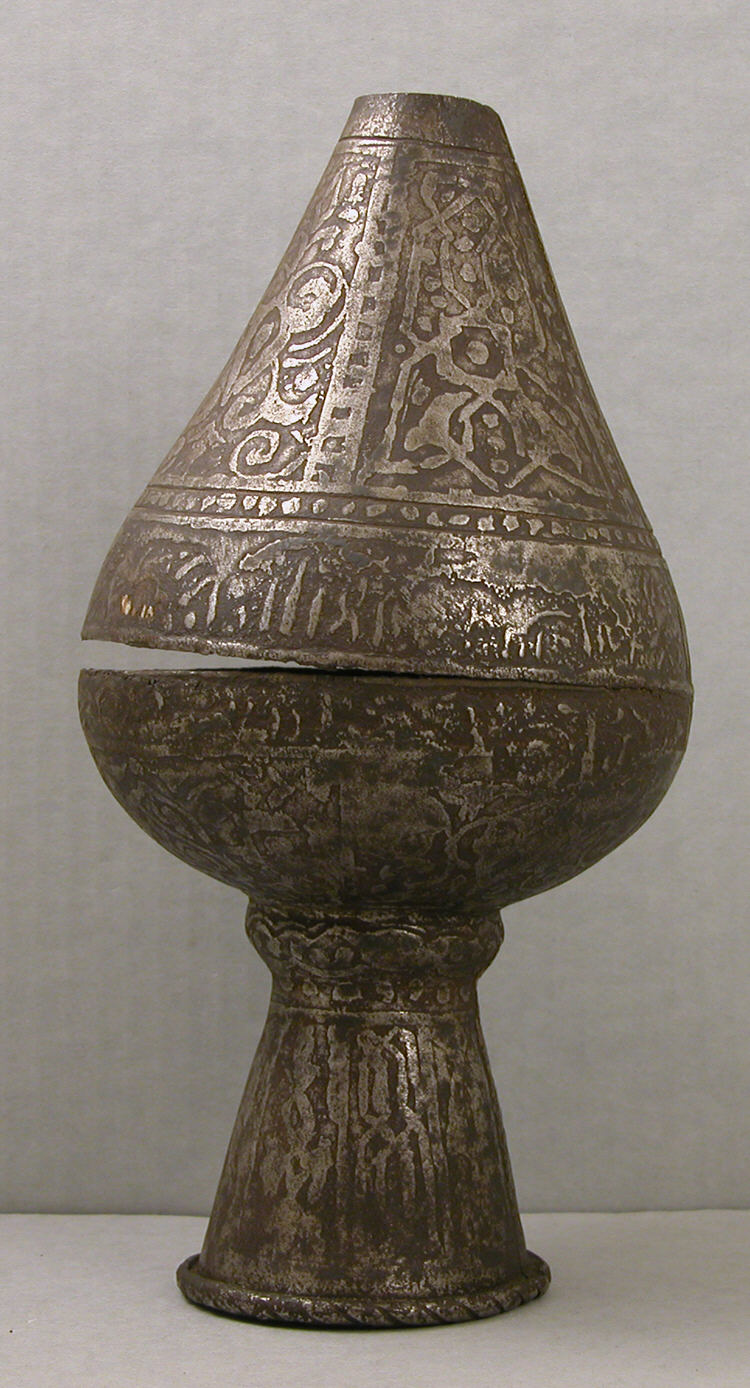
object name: finial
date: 1767-1800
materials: iron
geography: india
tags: arabic